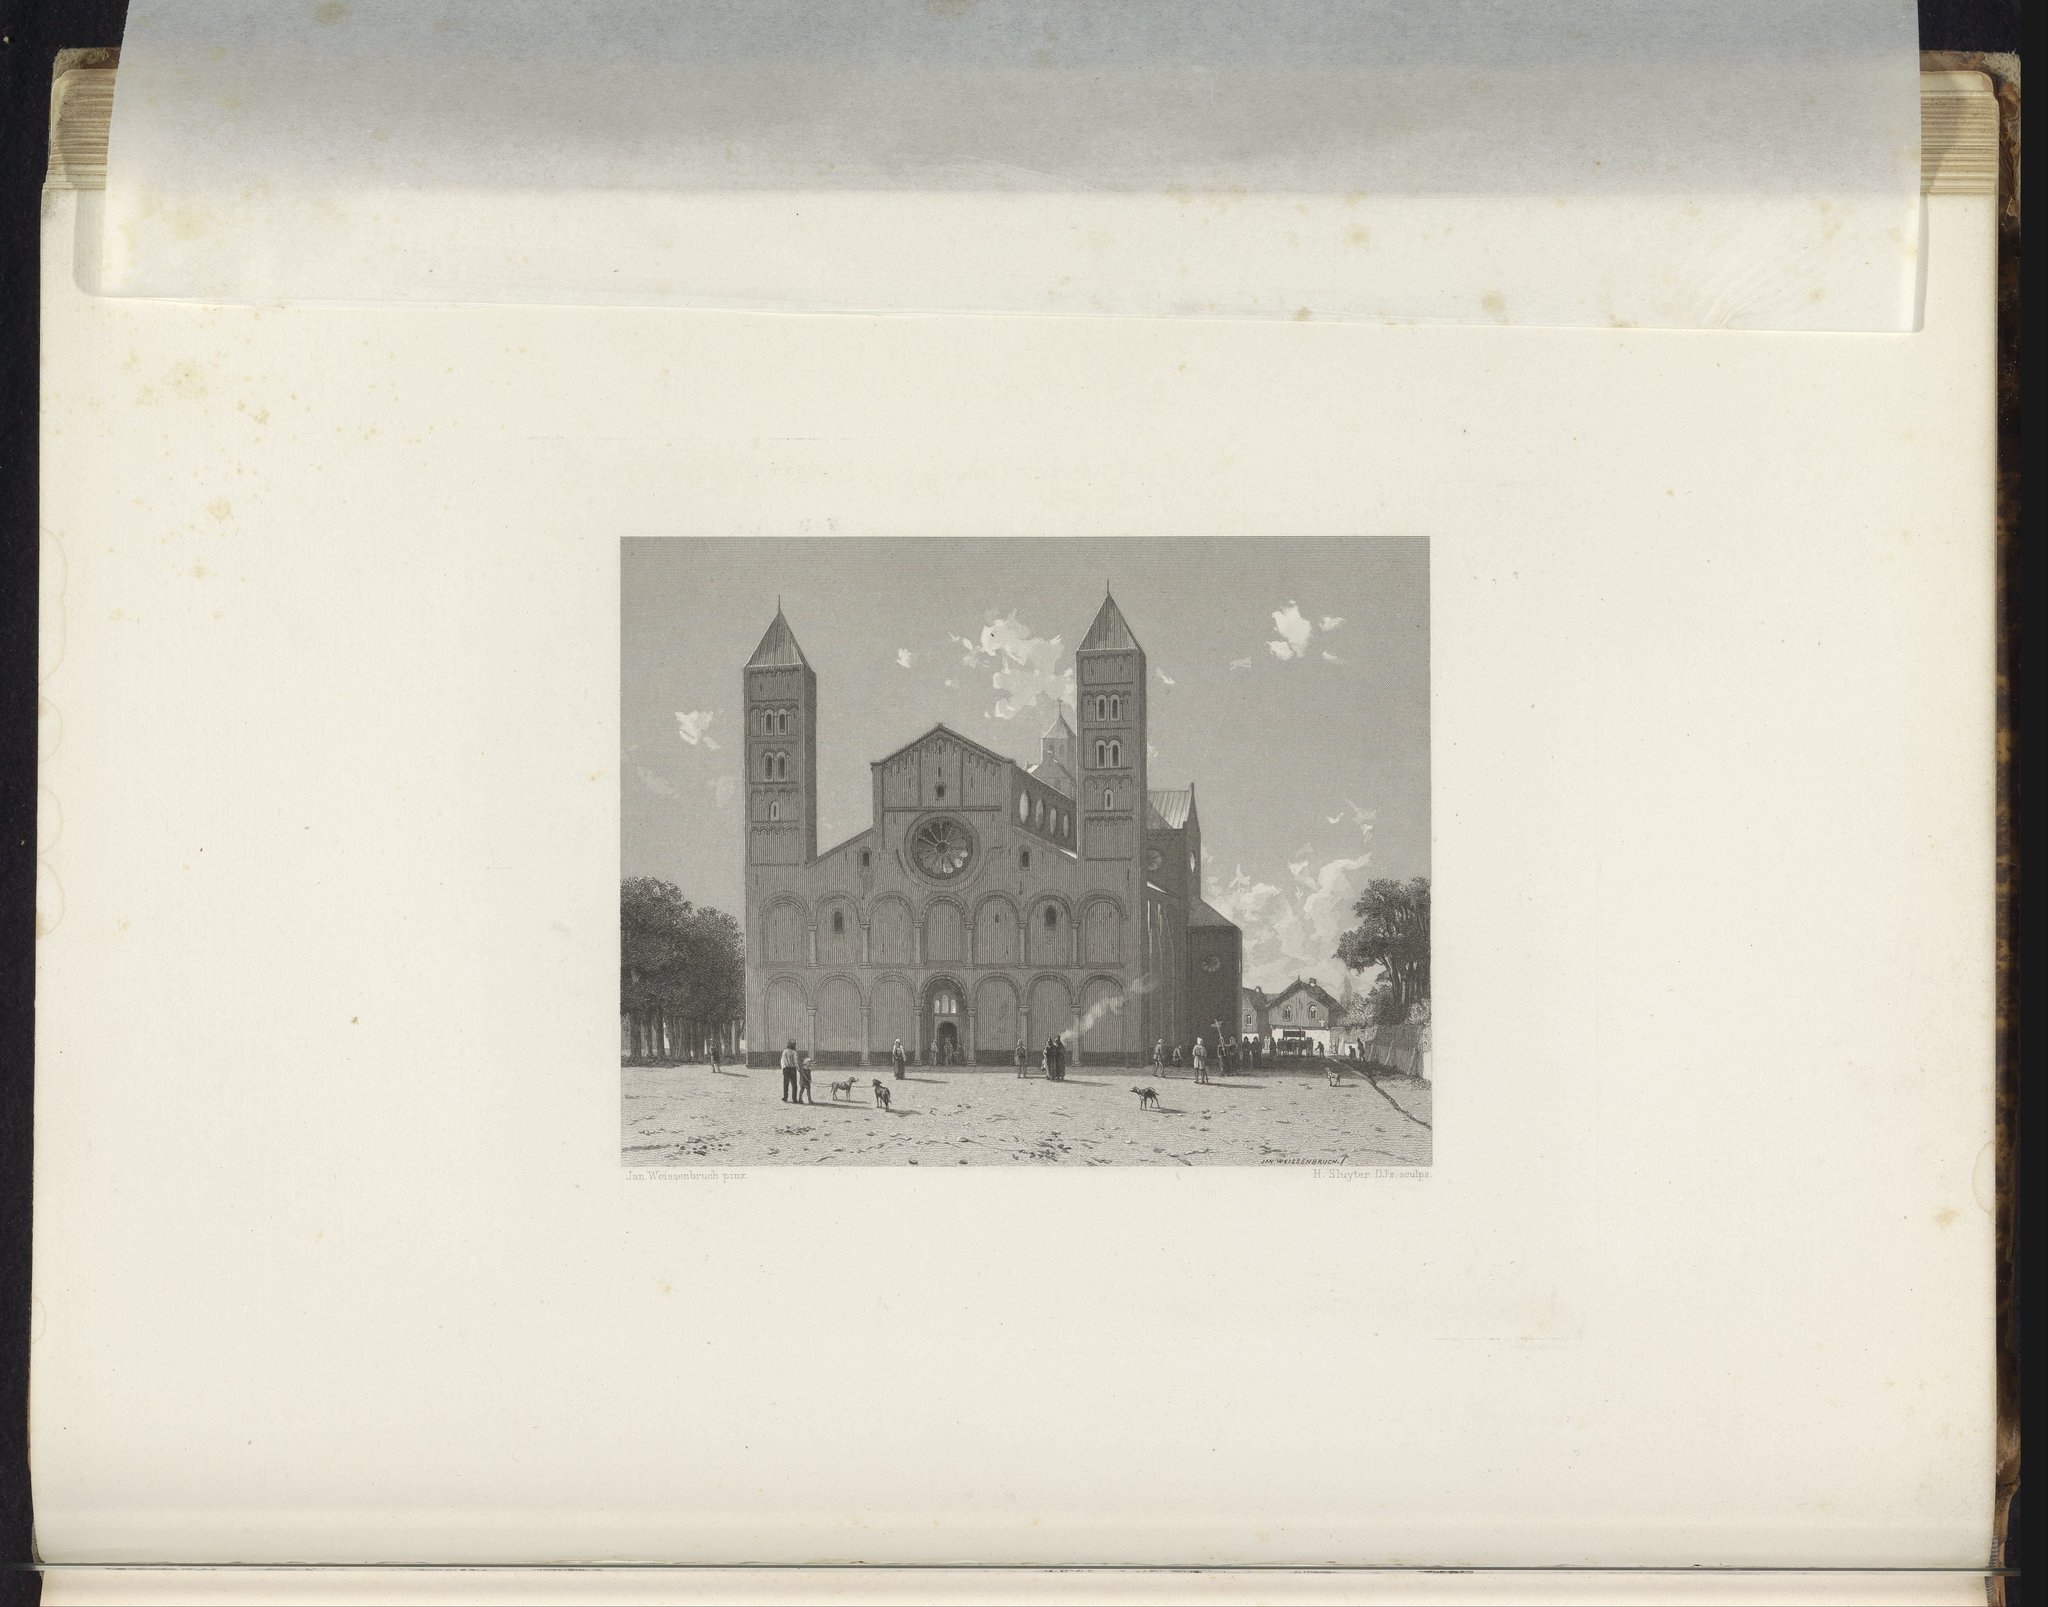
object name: history print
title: De St. Marie-kerk te Utrecht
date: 1865-1870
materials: paper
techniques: engraving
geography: netherlands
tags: exploration, expedition, voyage of discovery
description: Gezicht op de Sint Marie-Kerk, Mariakerk, te Utrecht in het jaar 1090. Onderdeel van de groep staalgravures naar de schilderijen van de Historische Galerij der Maatschappij Arti et Amicitiae.